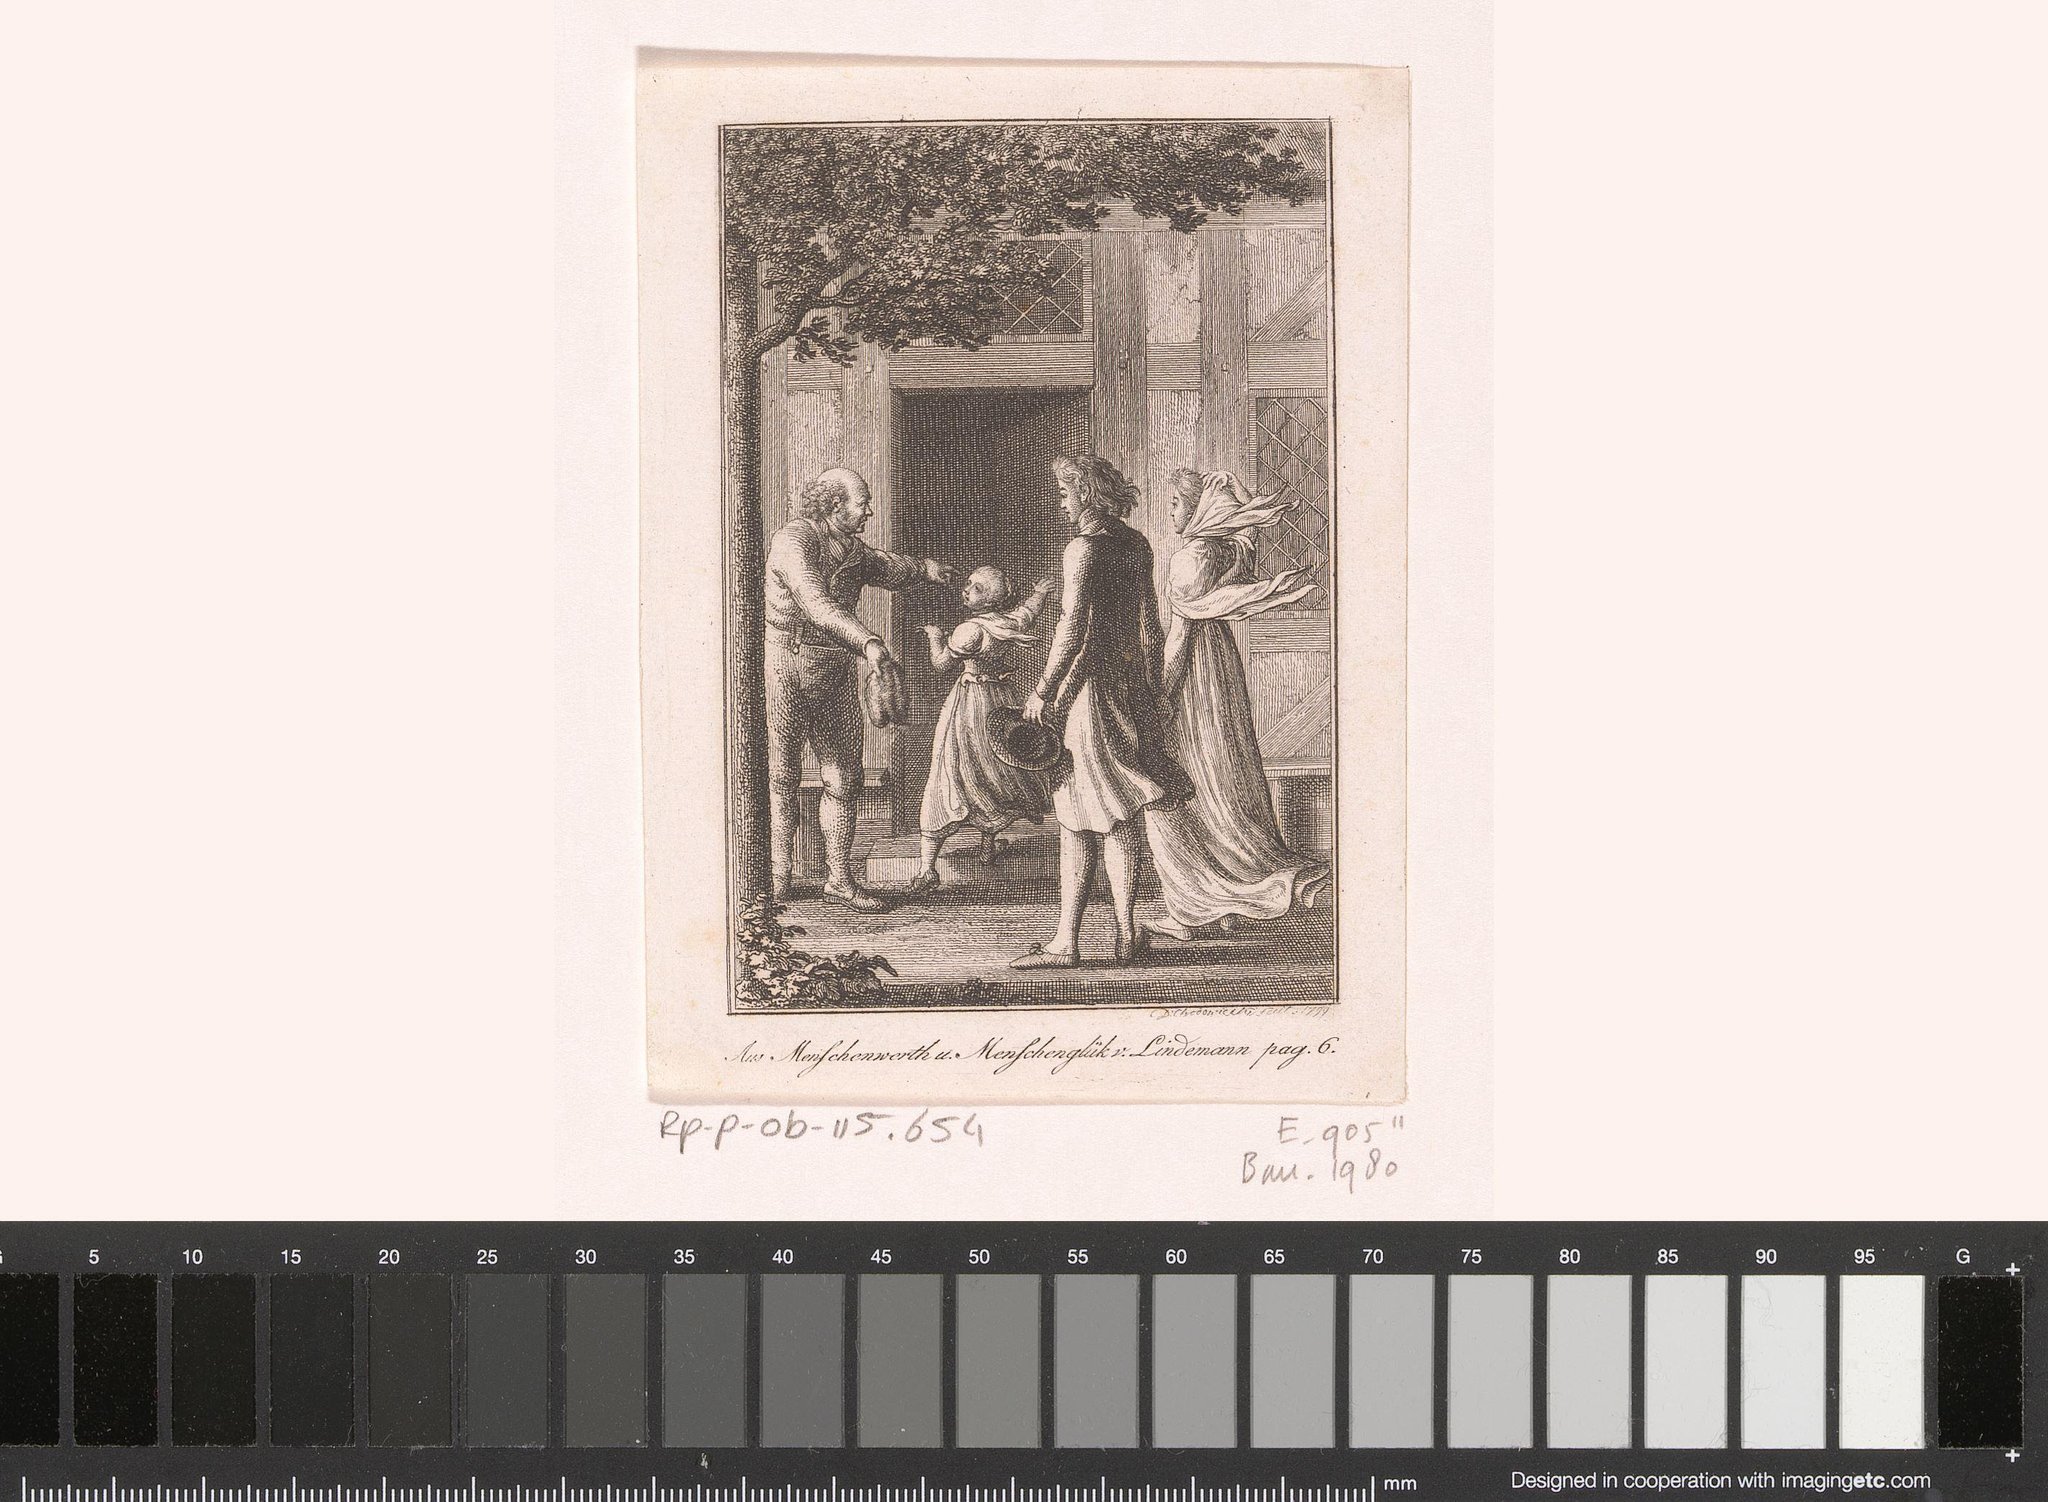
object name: print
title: Twee voorstellingen uit menselijke waarde en geluk van Lindemann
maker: daniel nikolaus chodowiecki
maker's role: draughtsman, print maker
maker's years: 1726-1801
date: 1799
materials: paper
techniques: etching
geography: berlin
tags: visiting; receiving guests; elegant company, family, descendance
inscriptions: collector's mark: Lugt 2228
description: Prent gebruikt voor: Lang, Karl (onder pseud. August Lindemann). Taschenbuch für weisen und frohen Lebensgenuss 1800 (...). Altenau: Johann Friedrich Hammerich, [1799].